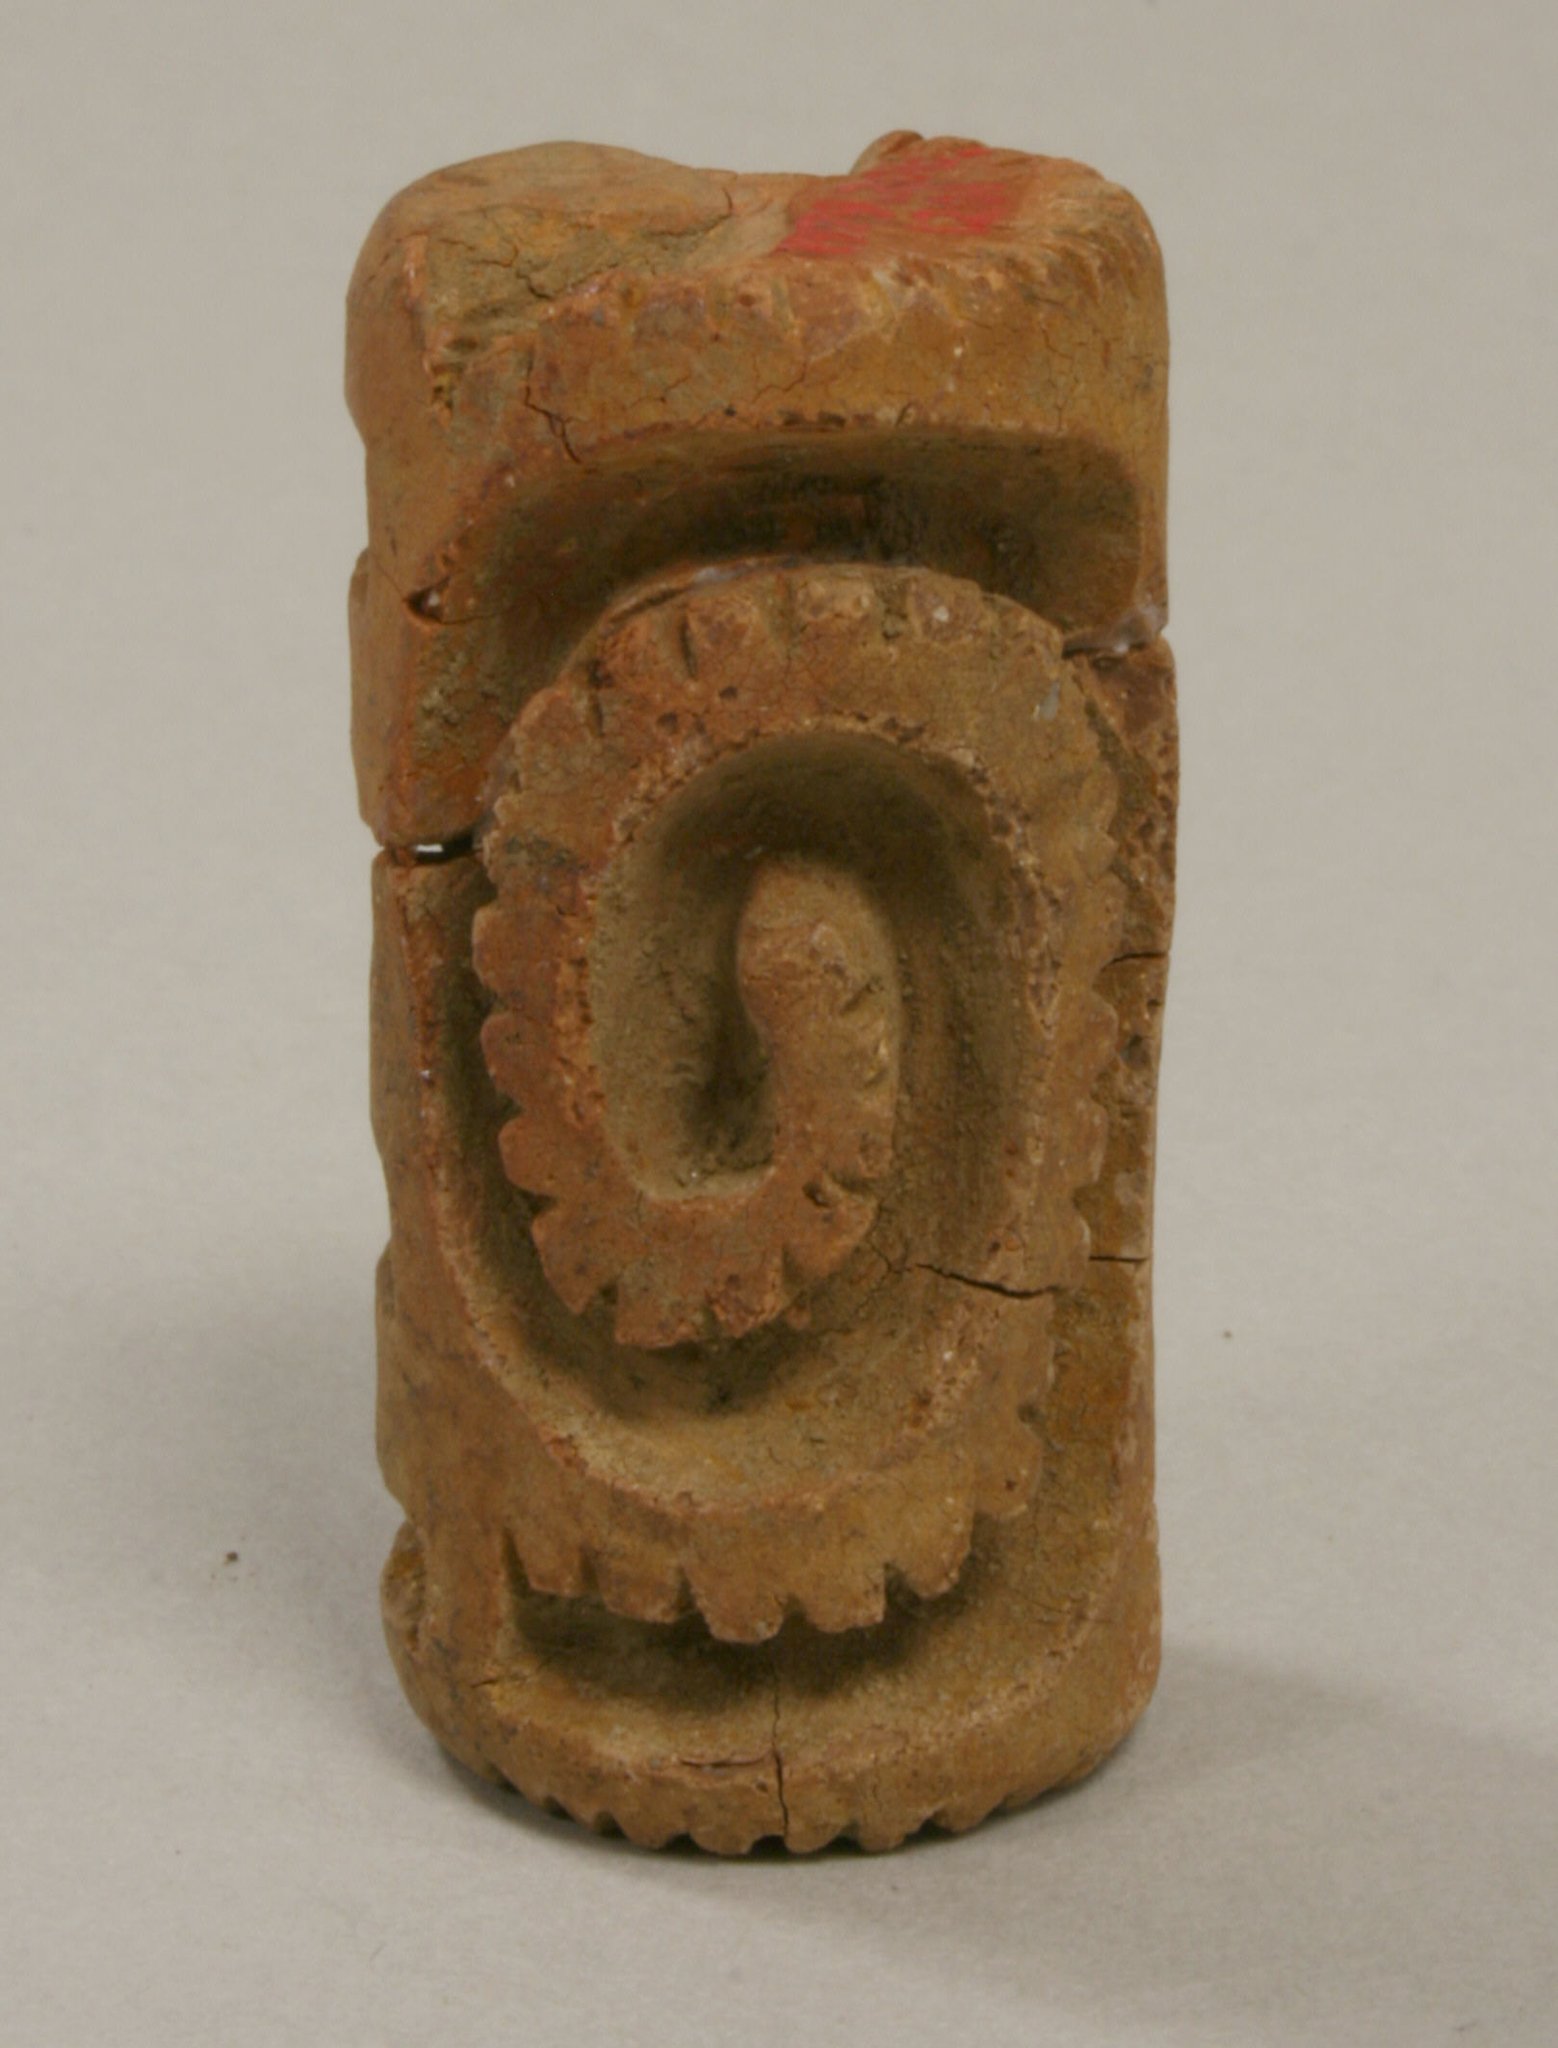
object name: stamp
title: Roller Stamp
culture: atlantic watershed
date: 401-600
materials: ceramic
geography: costa rica